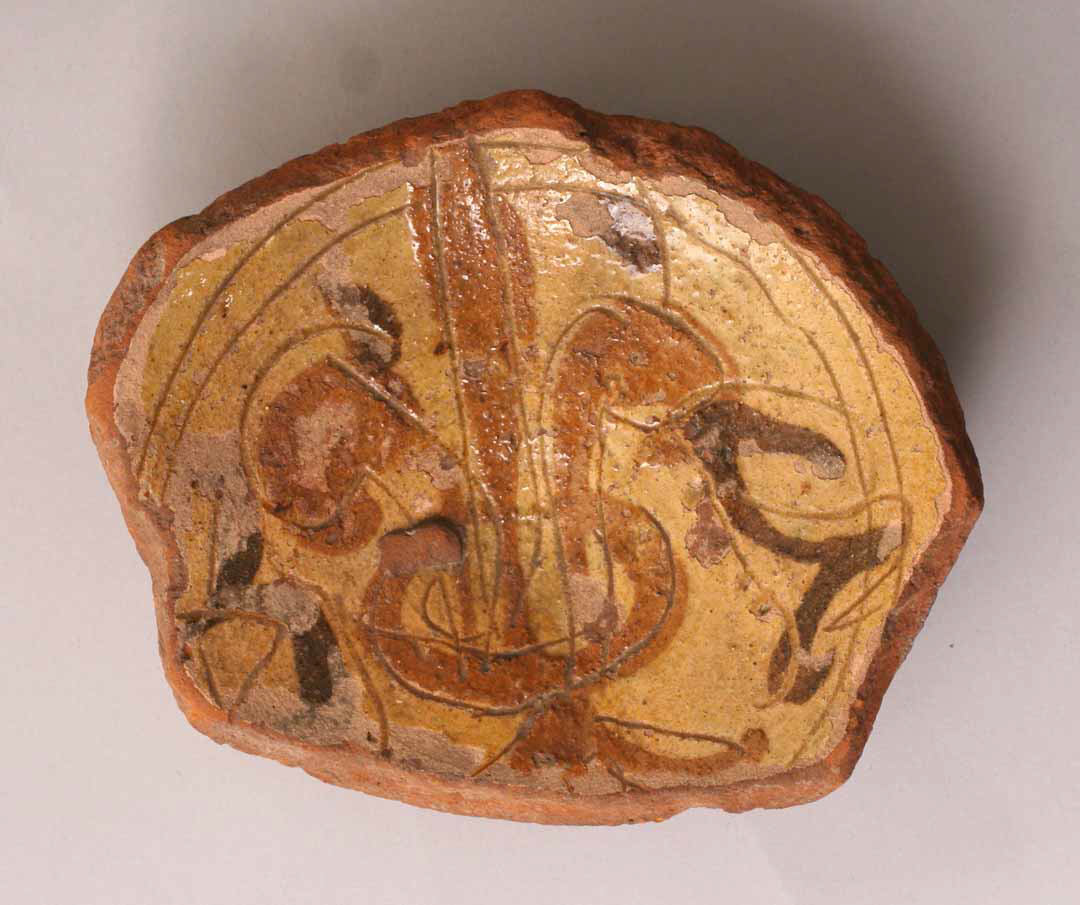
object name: fragment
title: Ceramic Fragment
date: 1301-1500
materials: earthenware, glaze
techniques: coloring, incising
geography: egypt